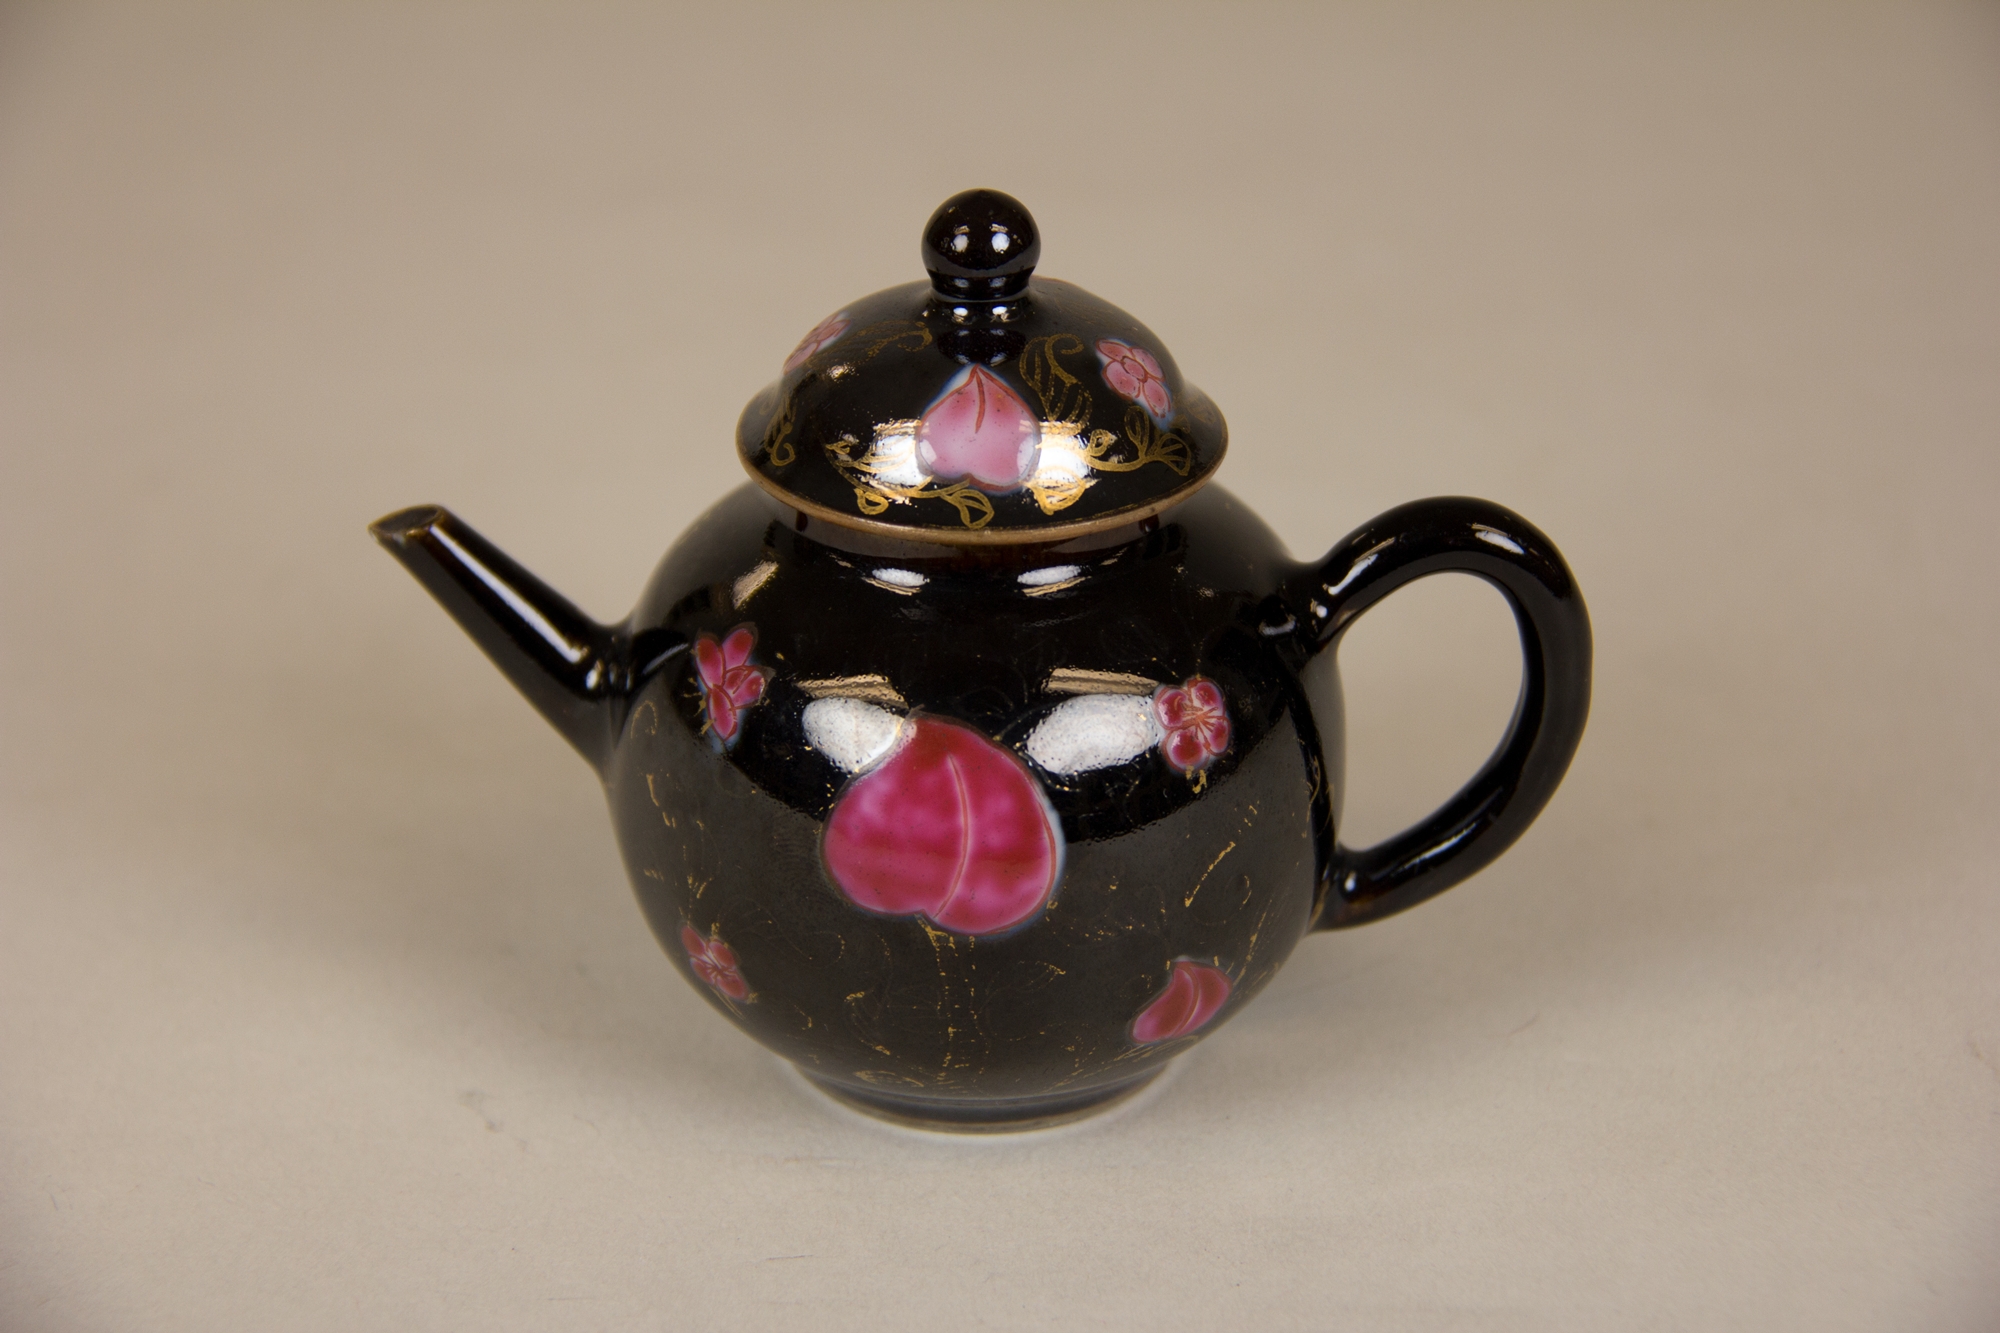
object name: teapot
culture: chinese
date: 1662-1722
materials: porcelain